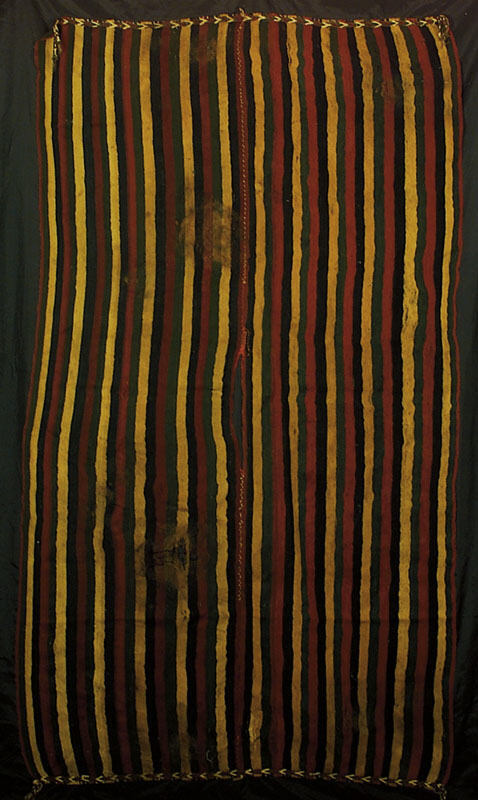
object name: tunic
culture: siguas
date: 1-700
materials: cotton, wool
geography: peru